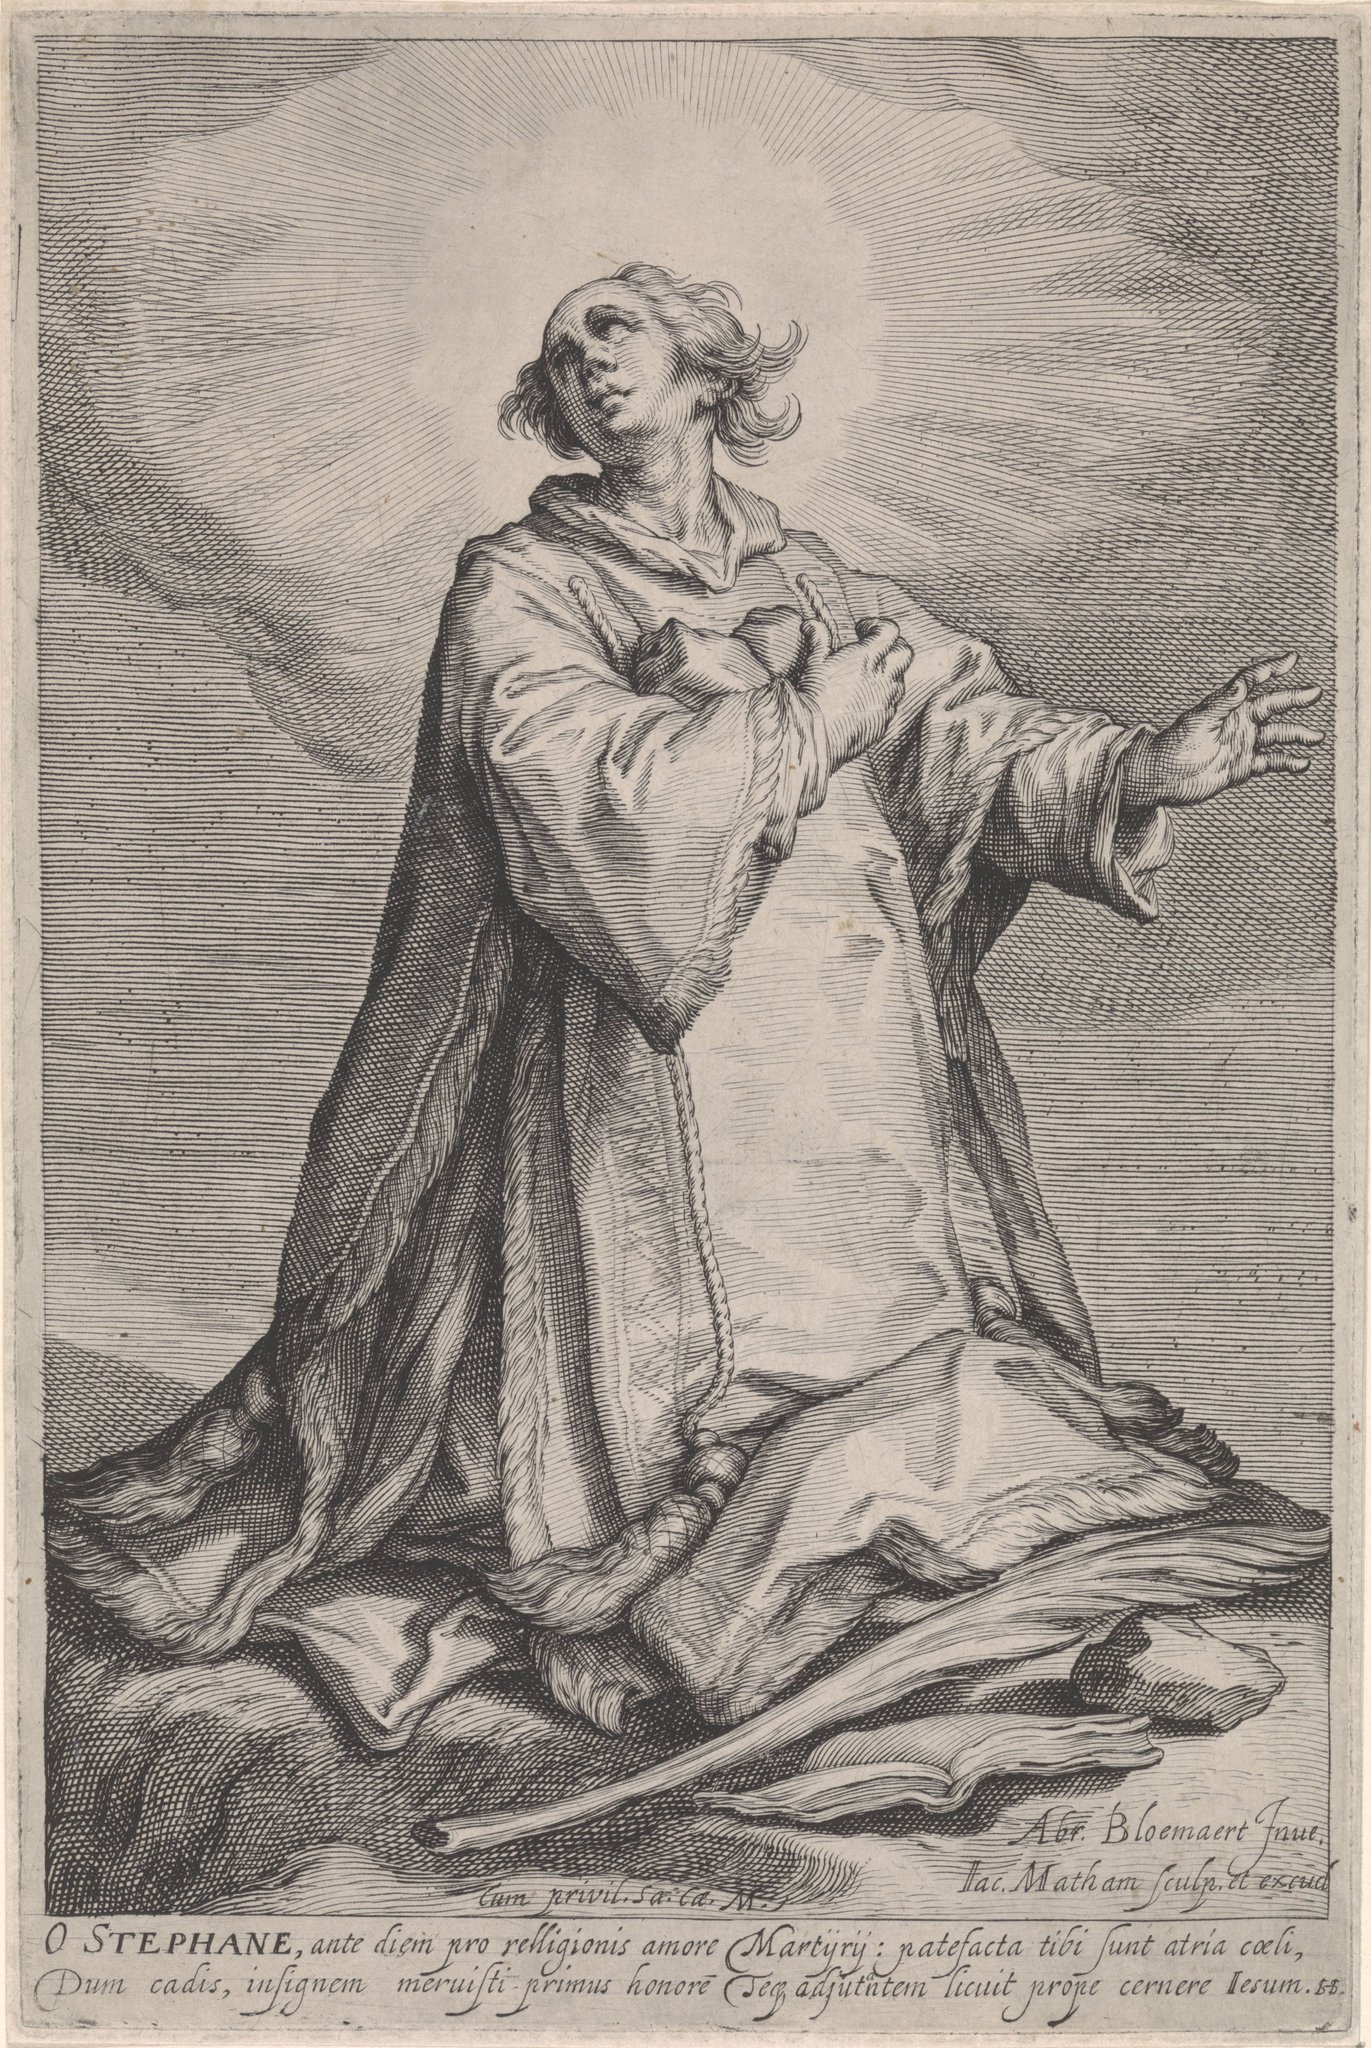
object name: print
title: Drie heiligen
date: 1605-1615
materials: paper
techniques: engraving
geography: haarlem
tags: the deacon and (proto)martyr stephen; possible attributes: censer, stones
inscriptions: collector's mark: Lugt 240